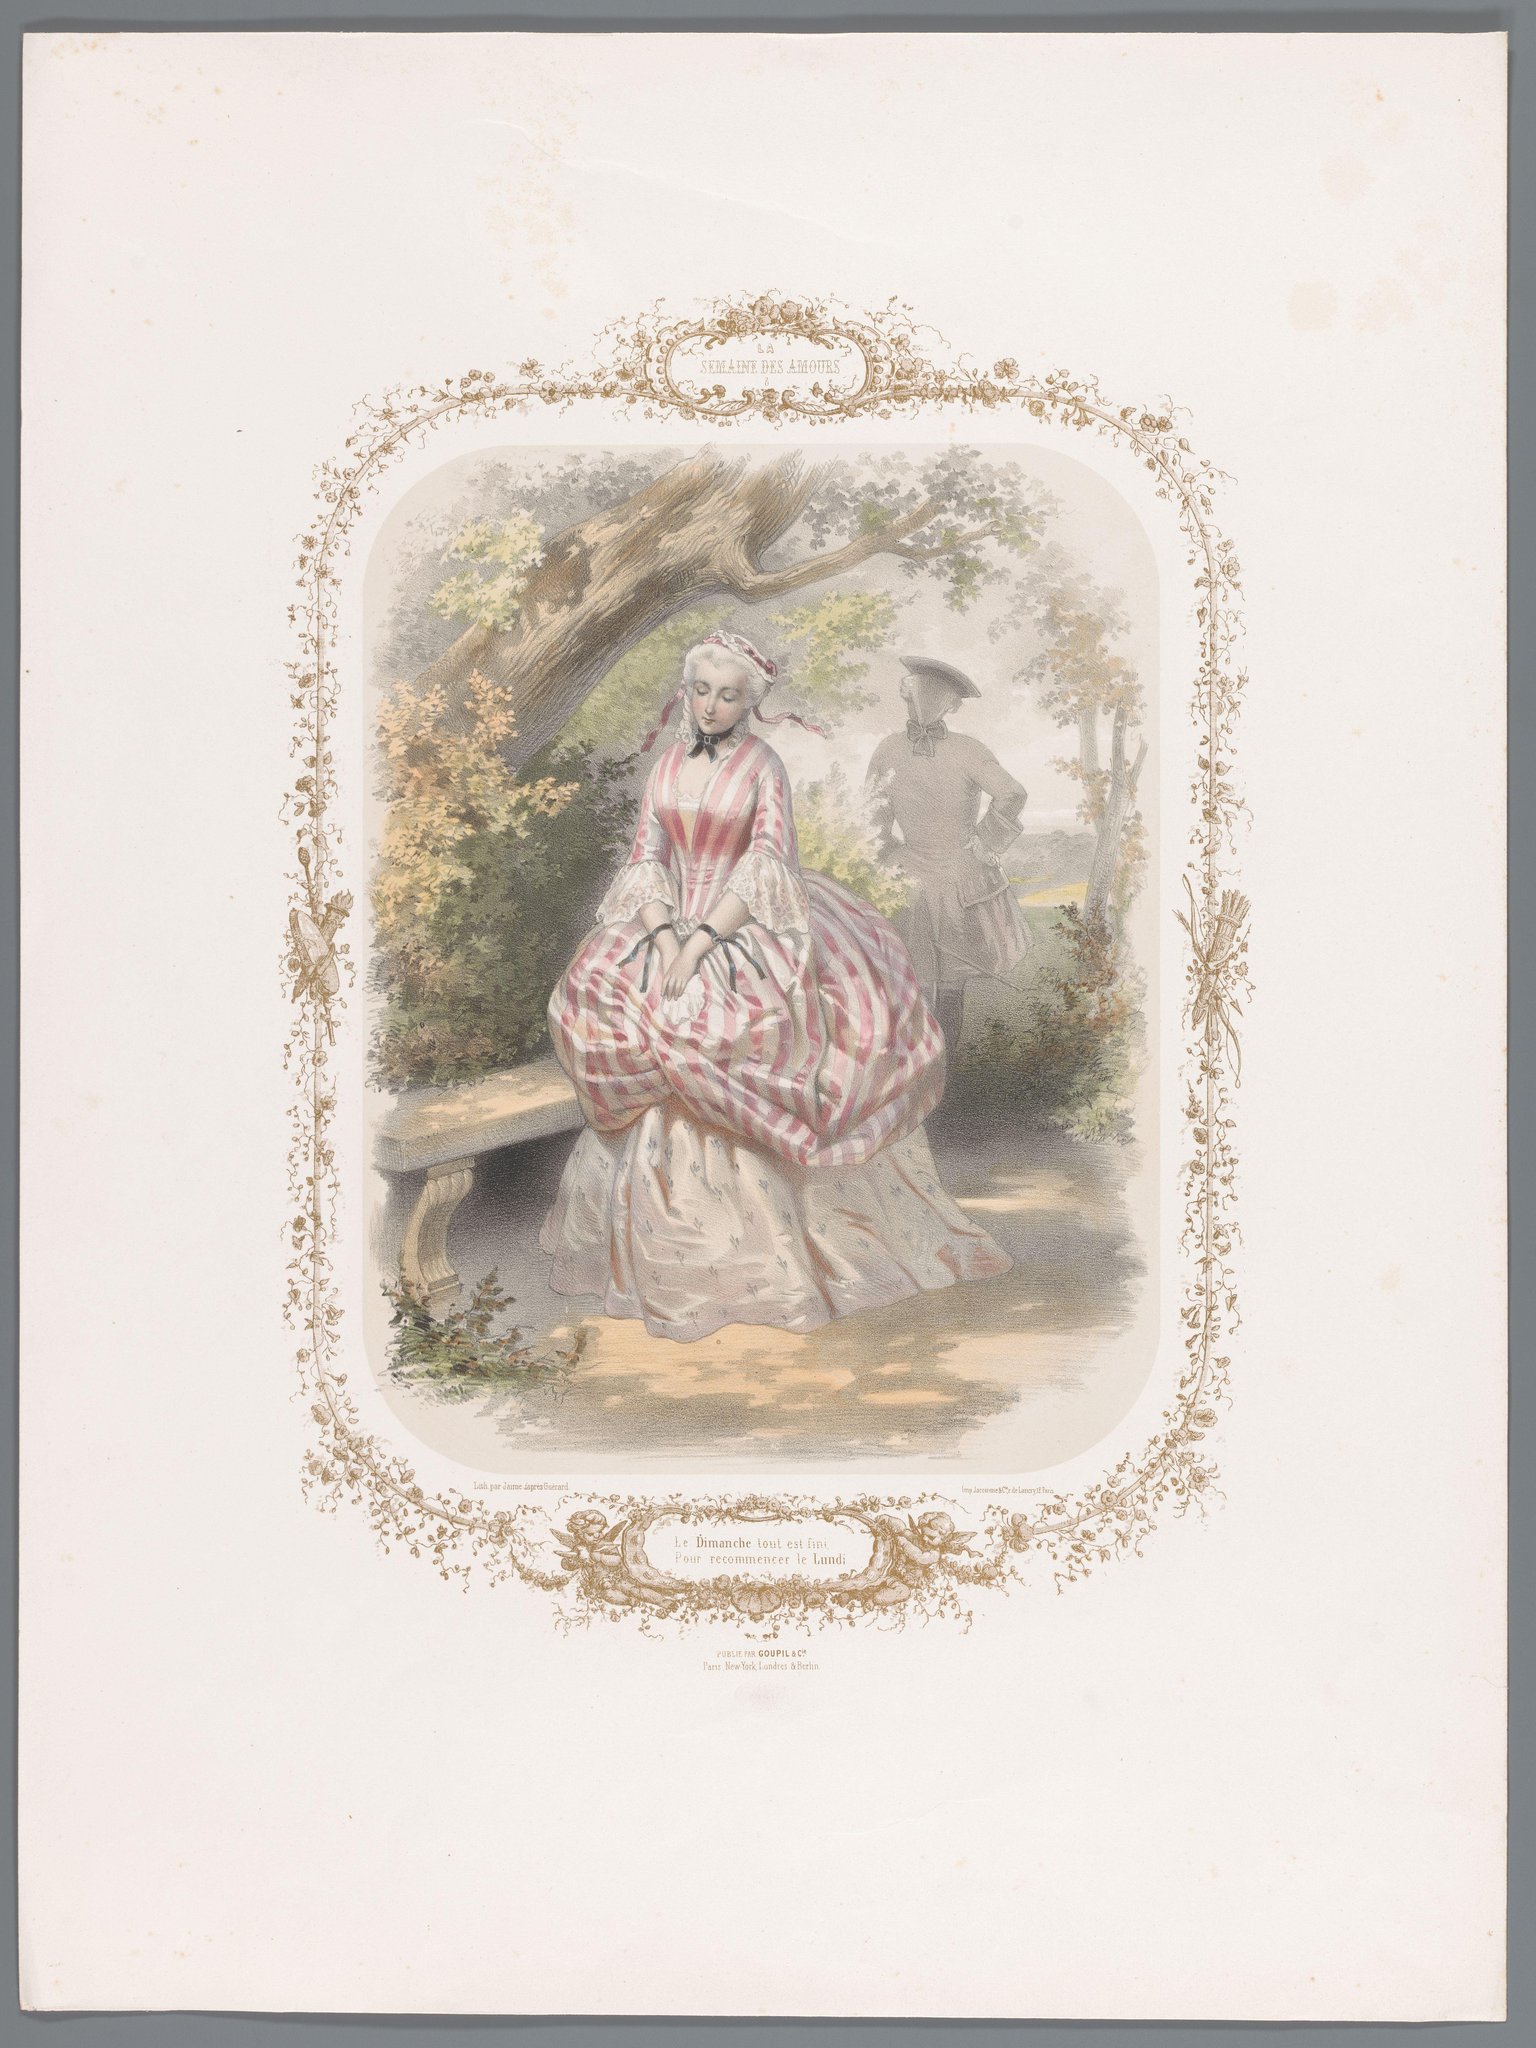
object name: print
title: La semaine des amours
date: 1852-1857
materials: paper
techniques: hand coloring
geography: paris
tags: dandy, beau, end of a love affair, fashionable woman, 'belle'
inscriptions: check stamp: Lugt 1090, collector's mark: Lugt 2233